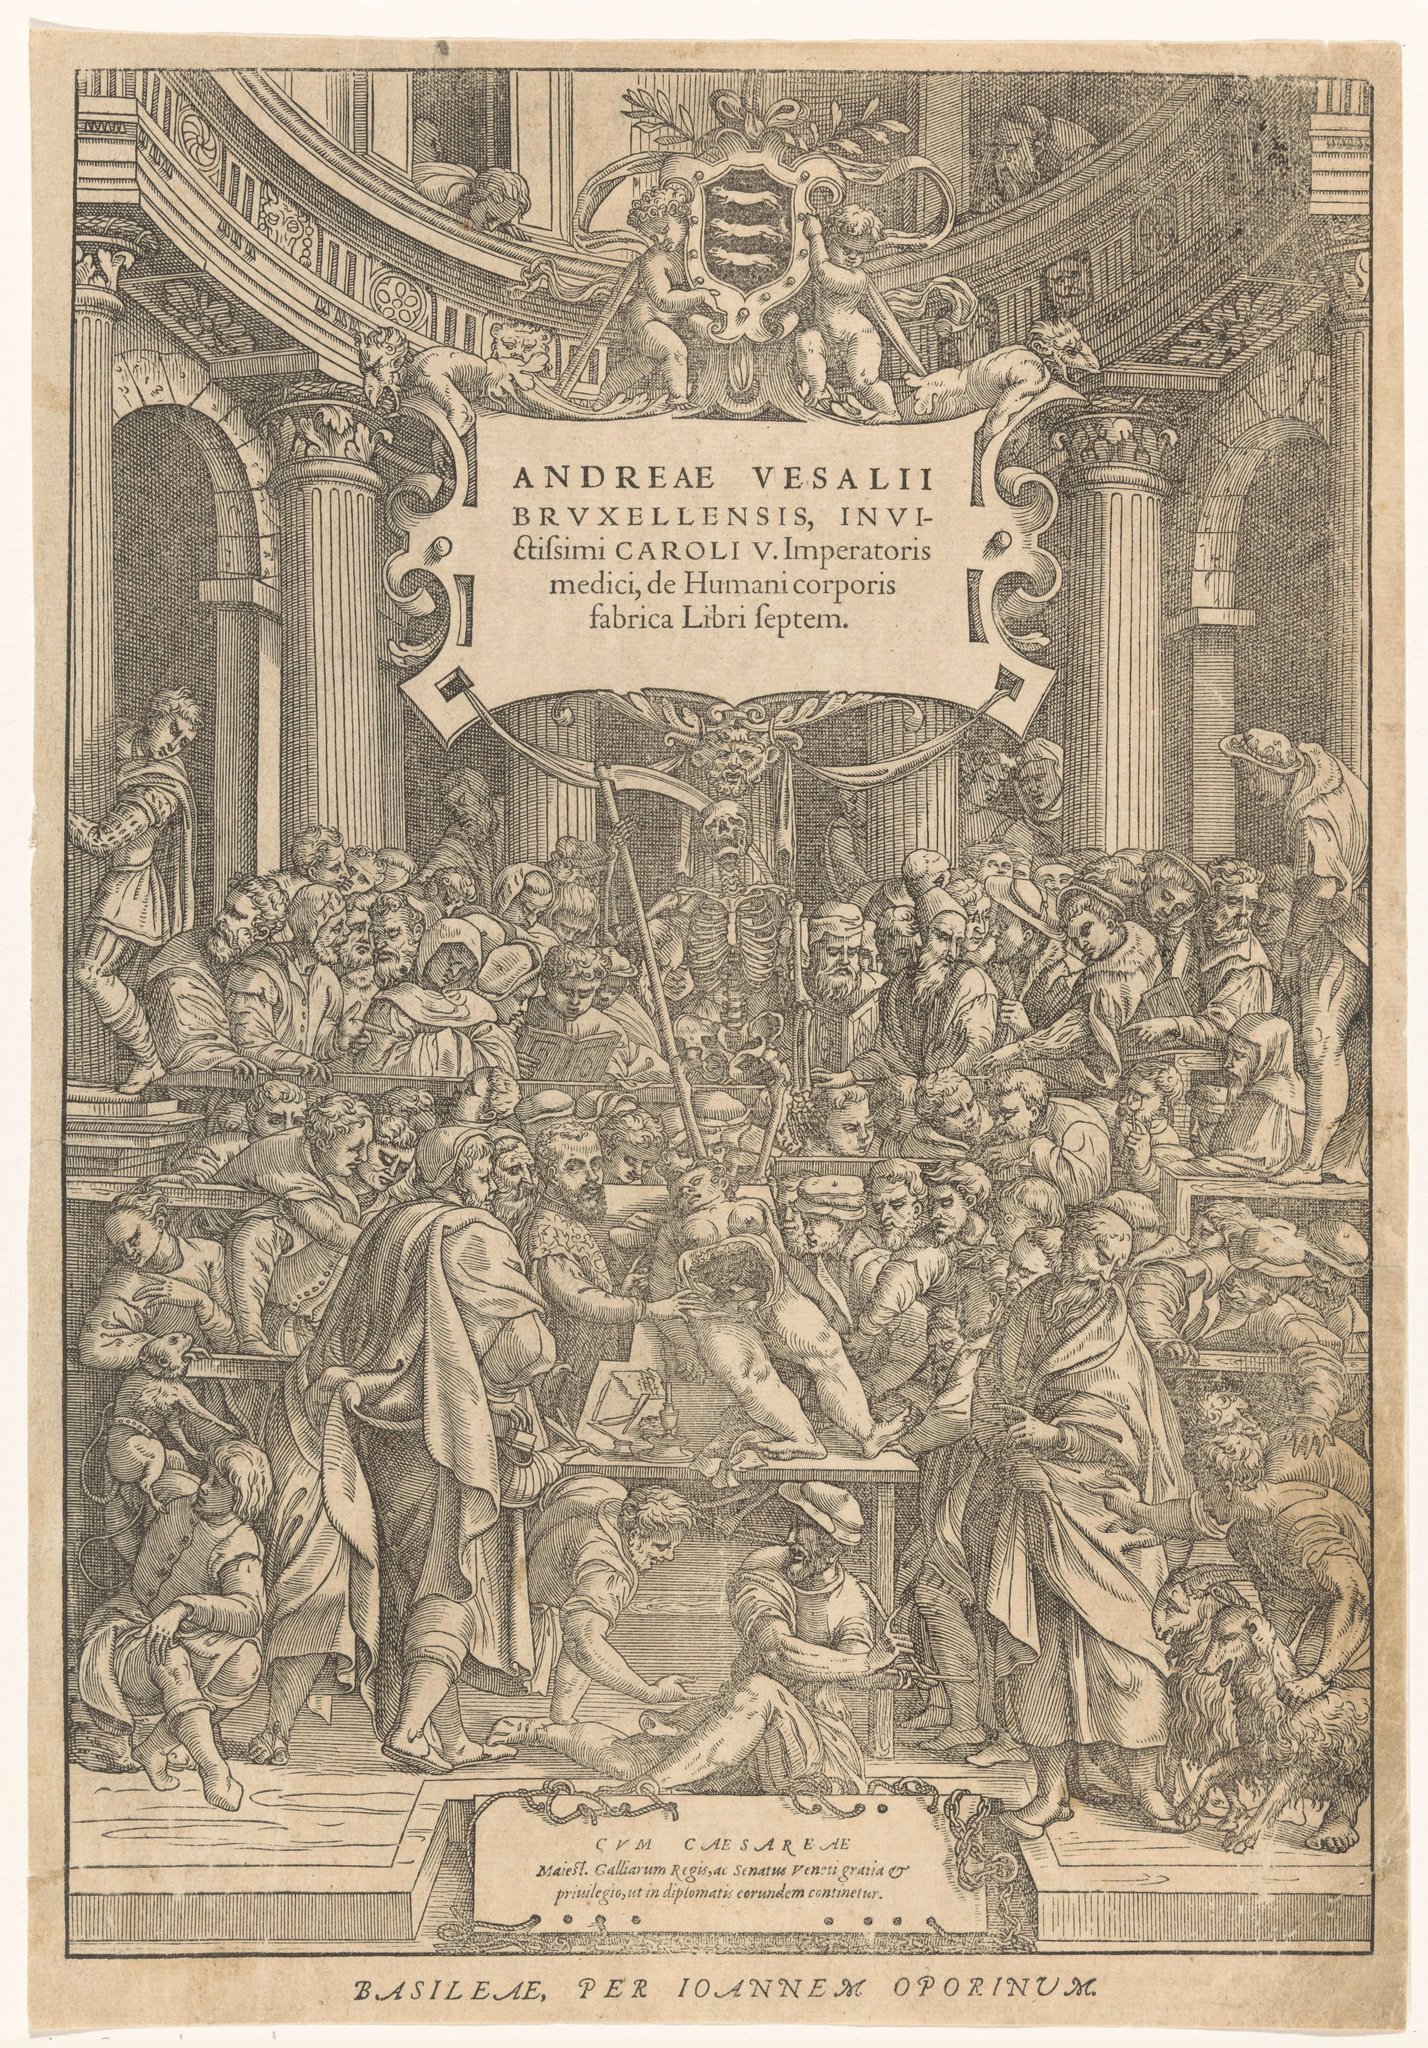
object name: titelblad, titelpagina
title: Andreae Vesalii Bruxellensis, invictissimi Caroli V. Imperatoris medici, de Humani corporis fabrica Libri septem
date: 1555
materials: paper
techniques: woodcut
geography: basel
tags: physiology and anatomy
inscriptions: collector's mark: Lugt 2228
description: Titelpagina voor: Vesalius, Andreas. De humani corporis fabrica. Bazel: Oporinus, Johannes, 1555.